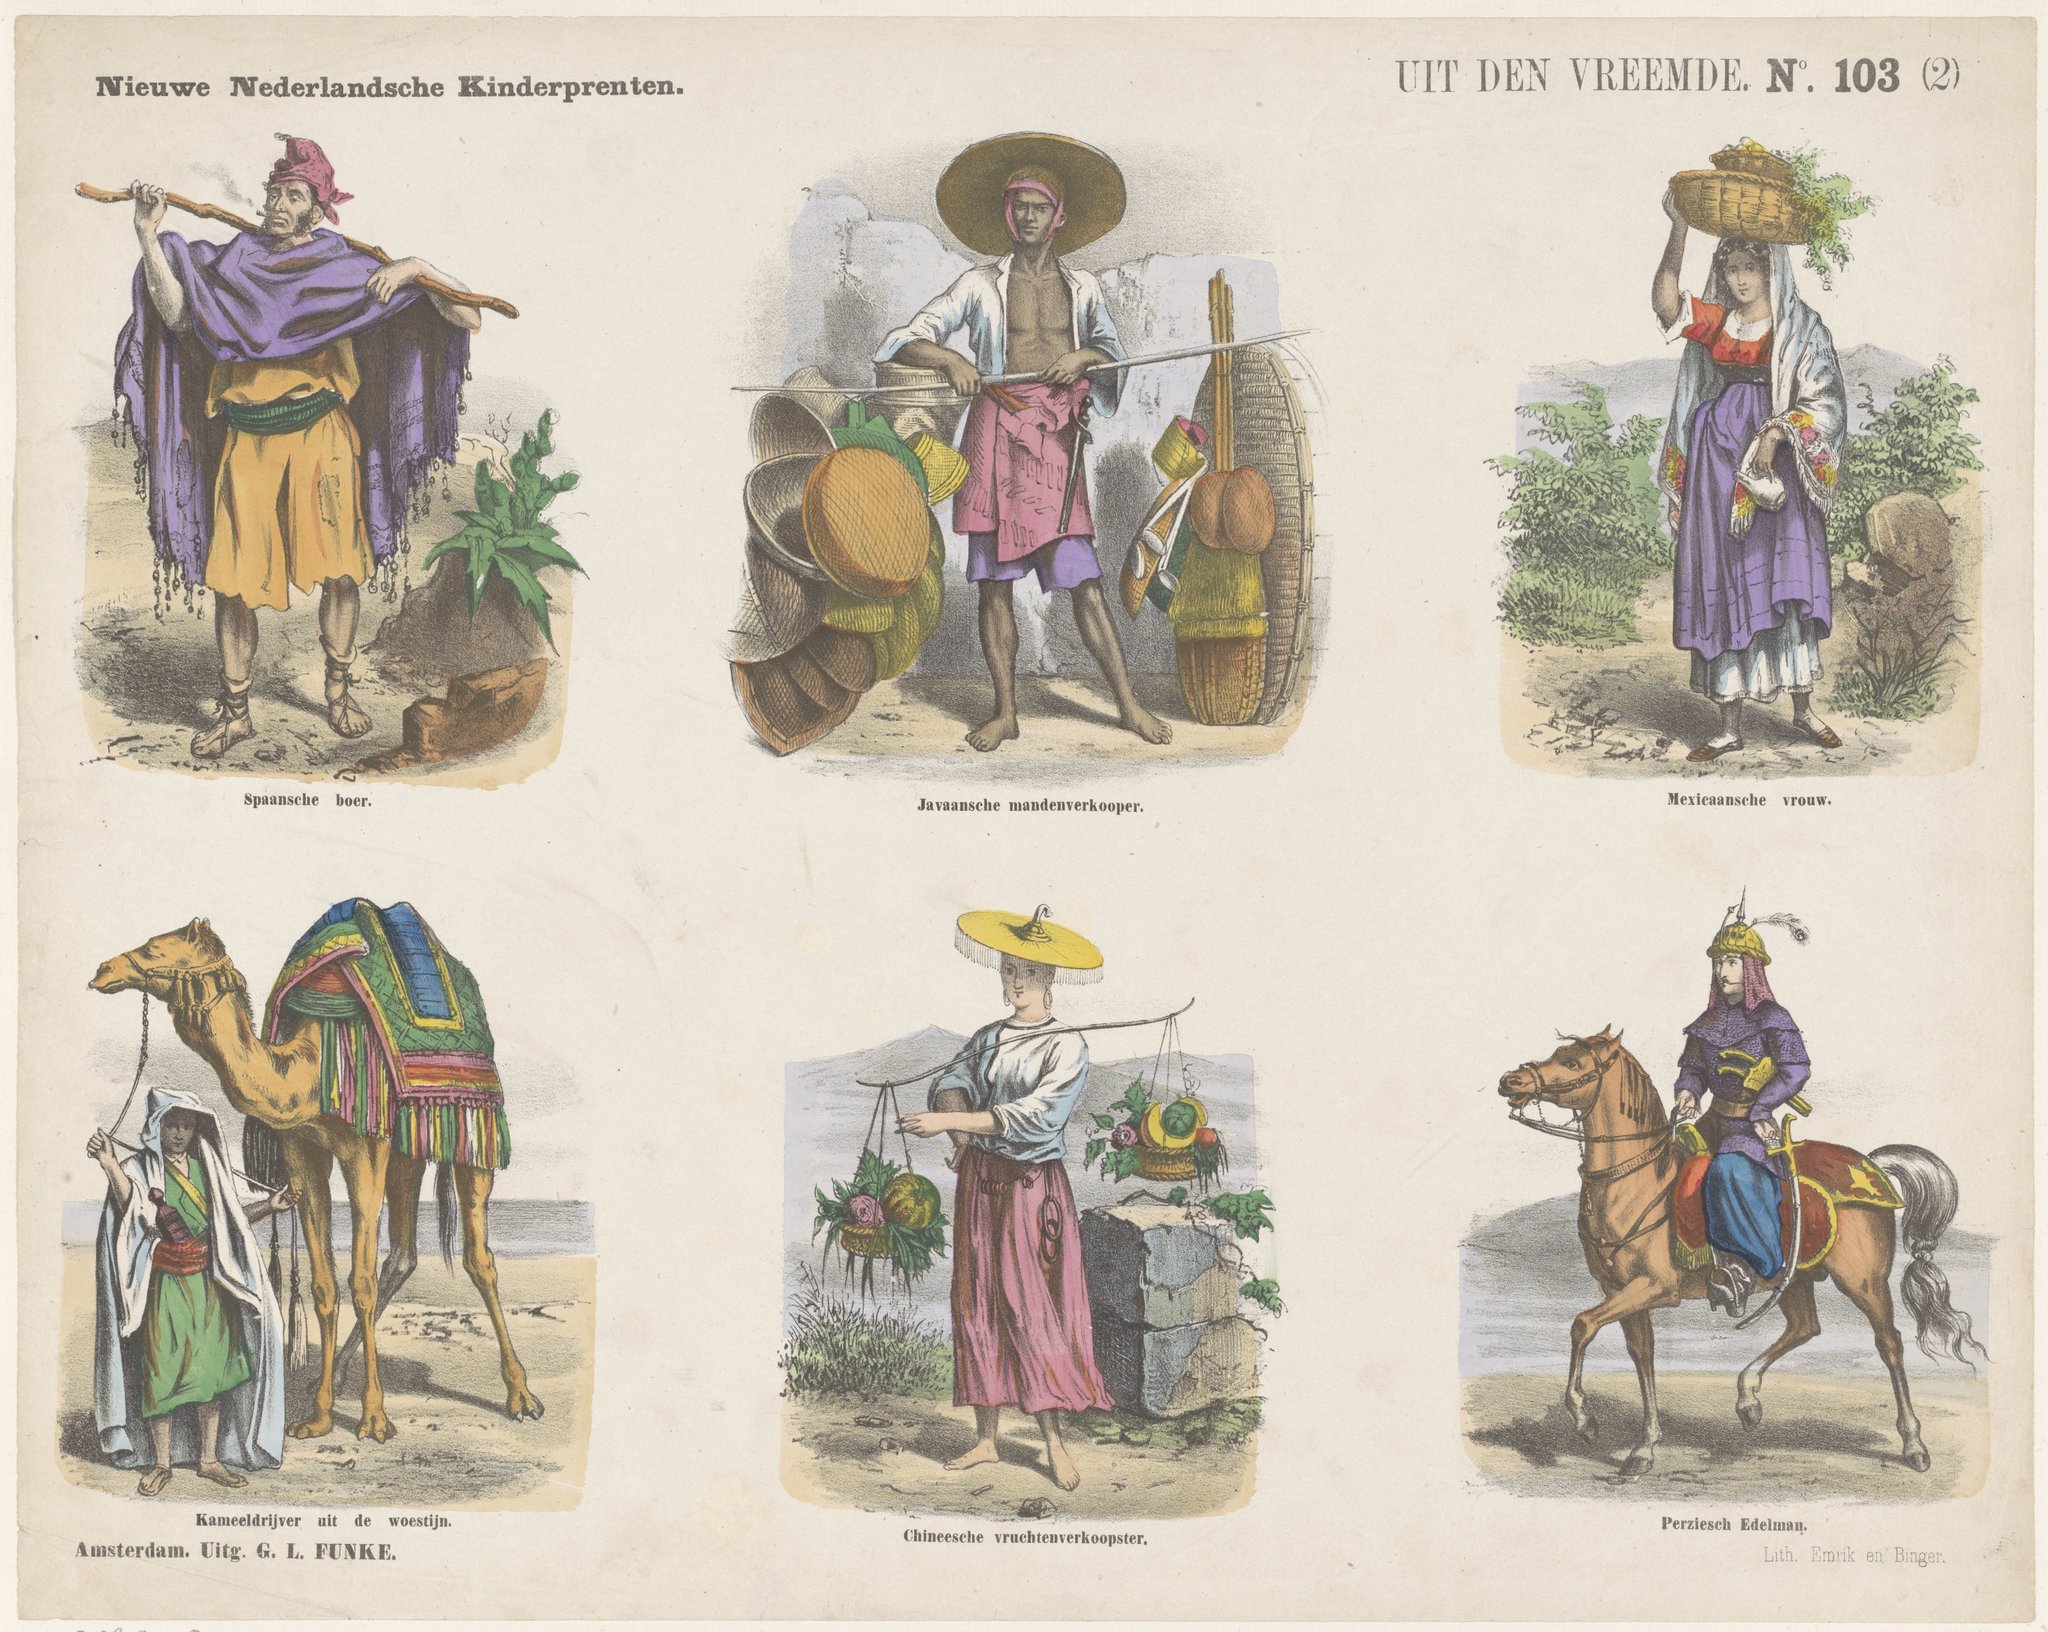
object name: popular print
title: Uit den vreemde / (2)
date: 1865-1875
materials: paper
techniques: colour, letterpress printing, lithograph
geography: haarlem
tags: farmers, characters (human types), street-trader, merchant, salesman, java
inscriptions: collector's mark: Lugt 2760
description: Blad met 6 voorstellingen van figuren uit verschillende delen van de wereld, bijvoorbeeld een Spaanse boer, een Javaanse mandenverkoper en een Chinese vruchtenverkoopster. Onder elke afbeelding een onderschrift. Genummerd rechtsboven: No. 103.